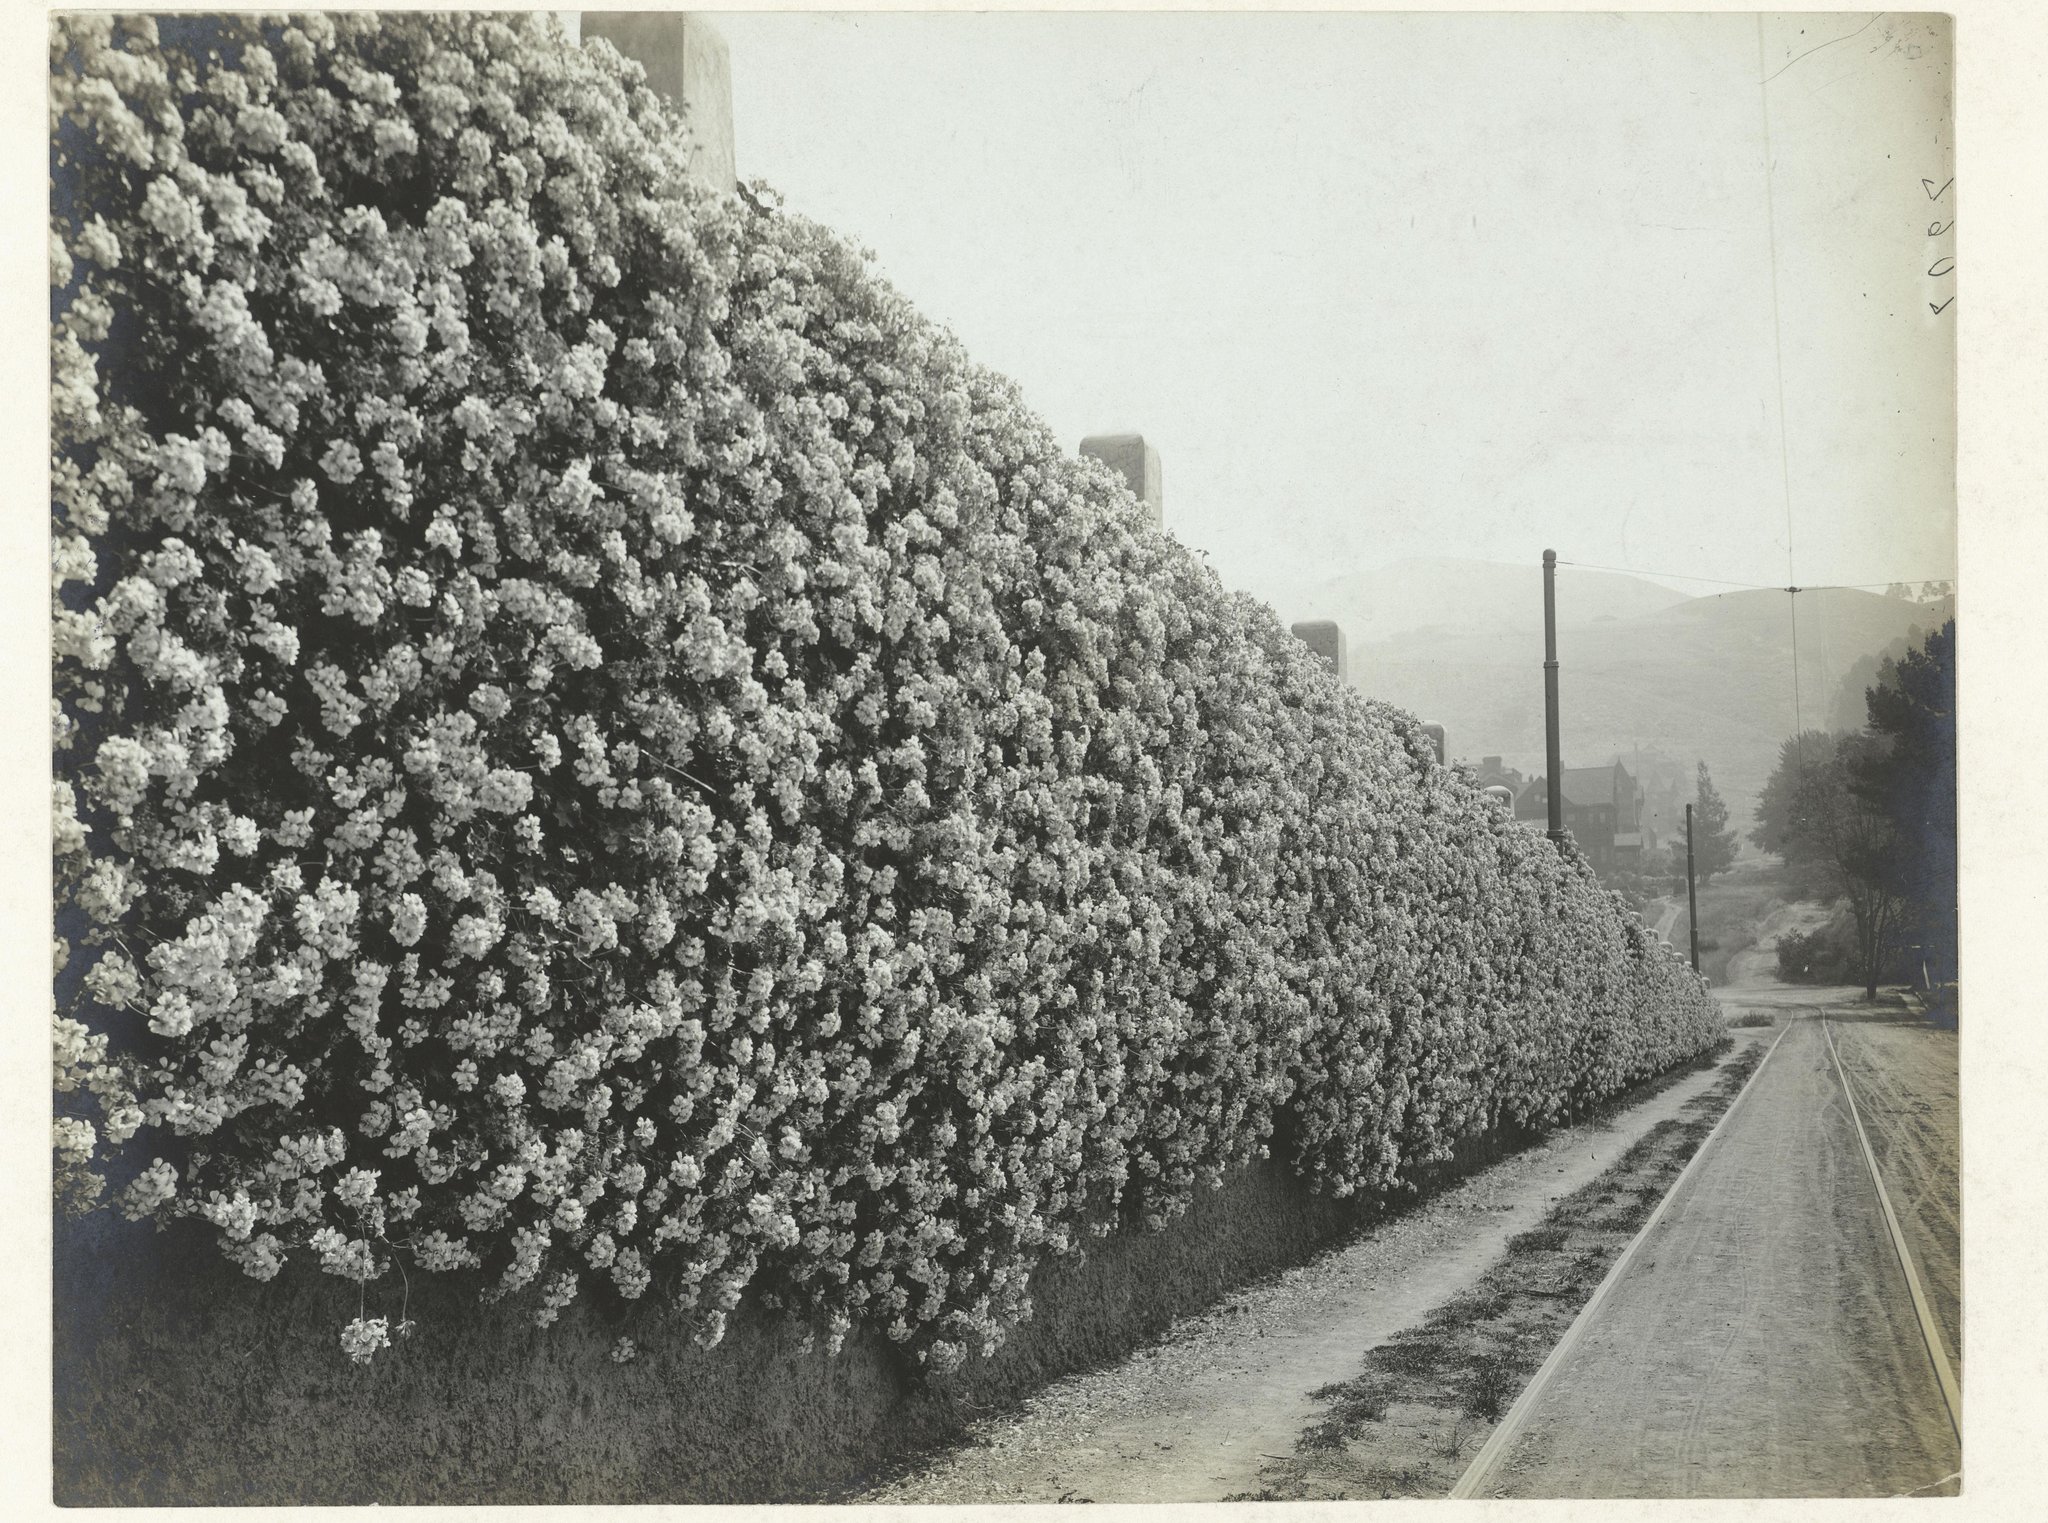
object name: photograph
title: Muur van geraniums, Berkeley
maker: Anonymous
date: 1890-1920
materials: paper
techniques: gelatin silver print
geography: berkeley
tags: flowers: geranium, fence, wall, paling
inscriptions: inscription: ‘V Haag met bloeiende/ geraniums’, inscription: ‘Wall of Geraniums/ Berkeley-/ California’, stamp: ‘On Line Southern Pacific’, number: ‘7202/ 7852’, number: ‘2907’